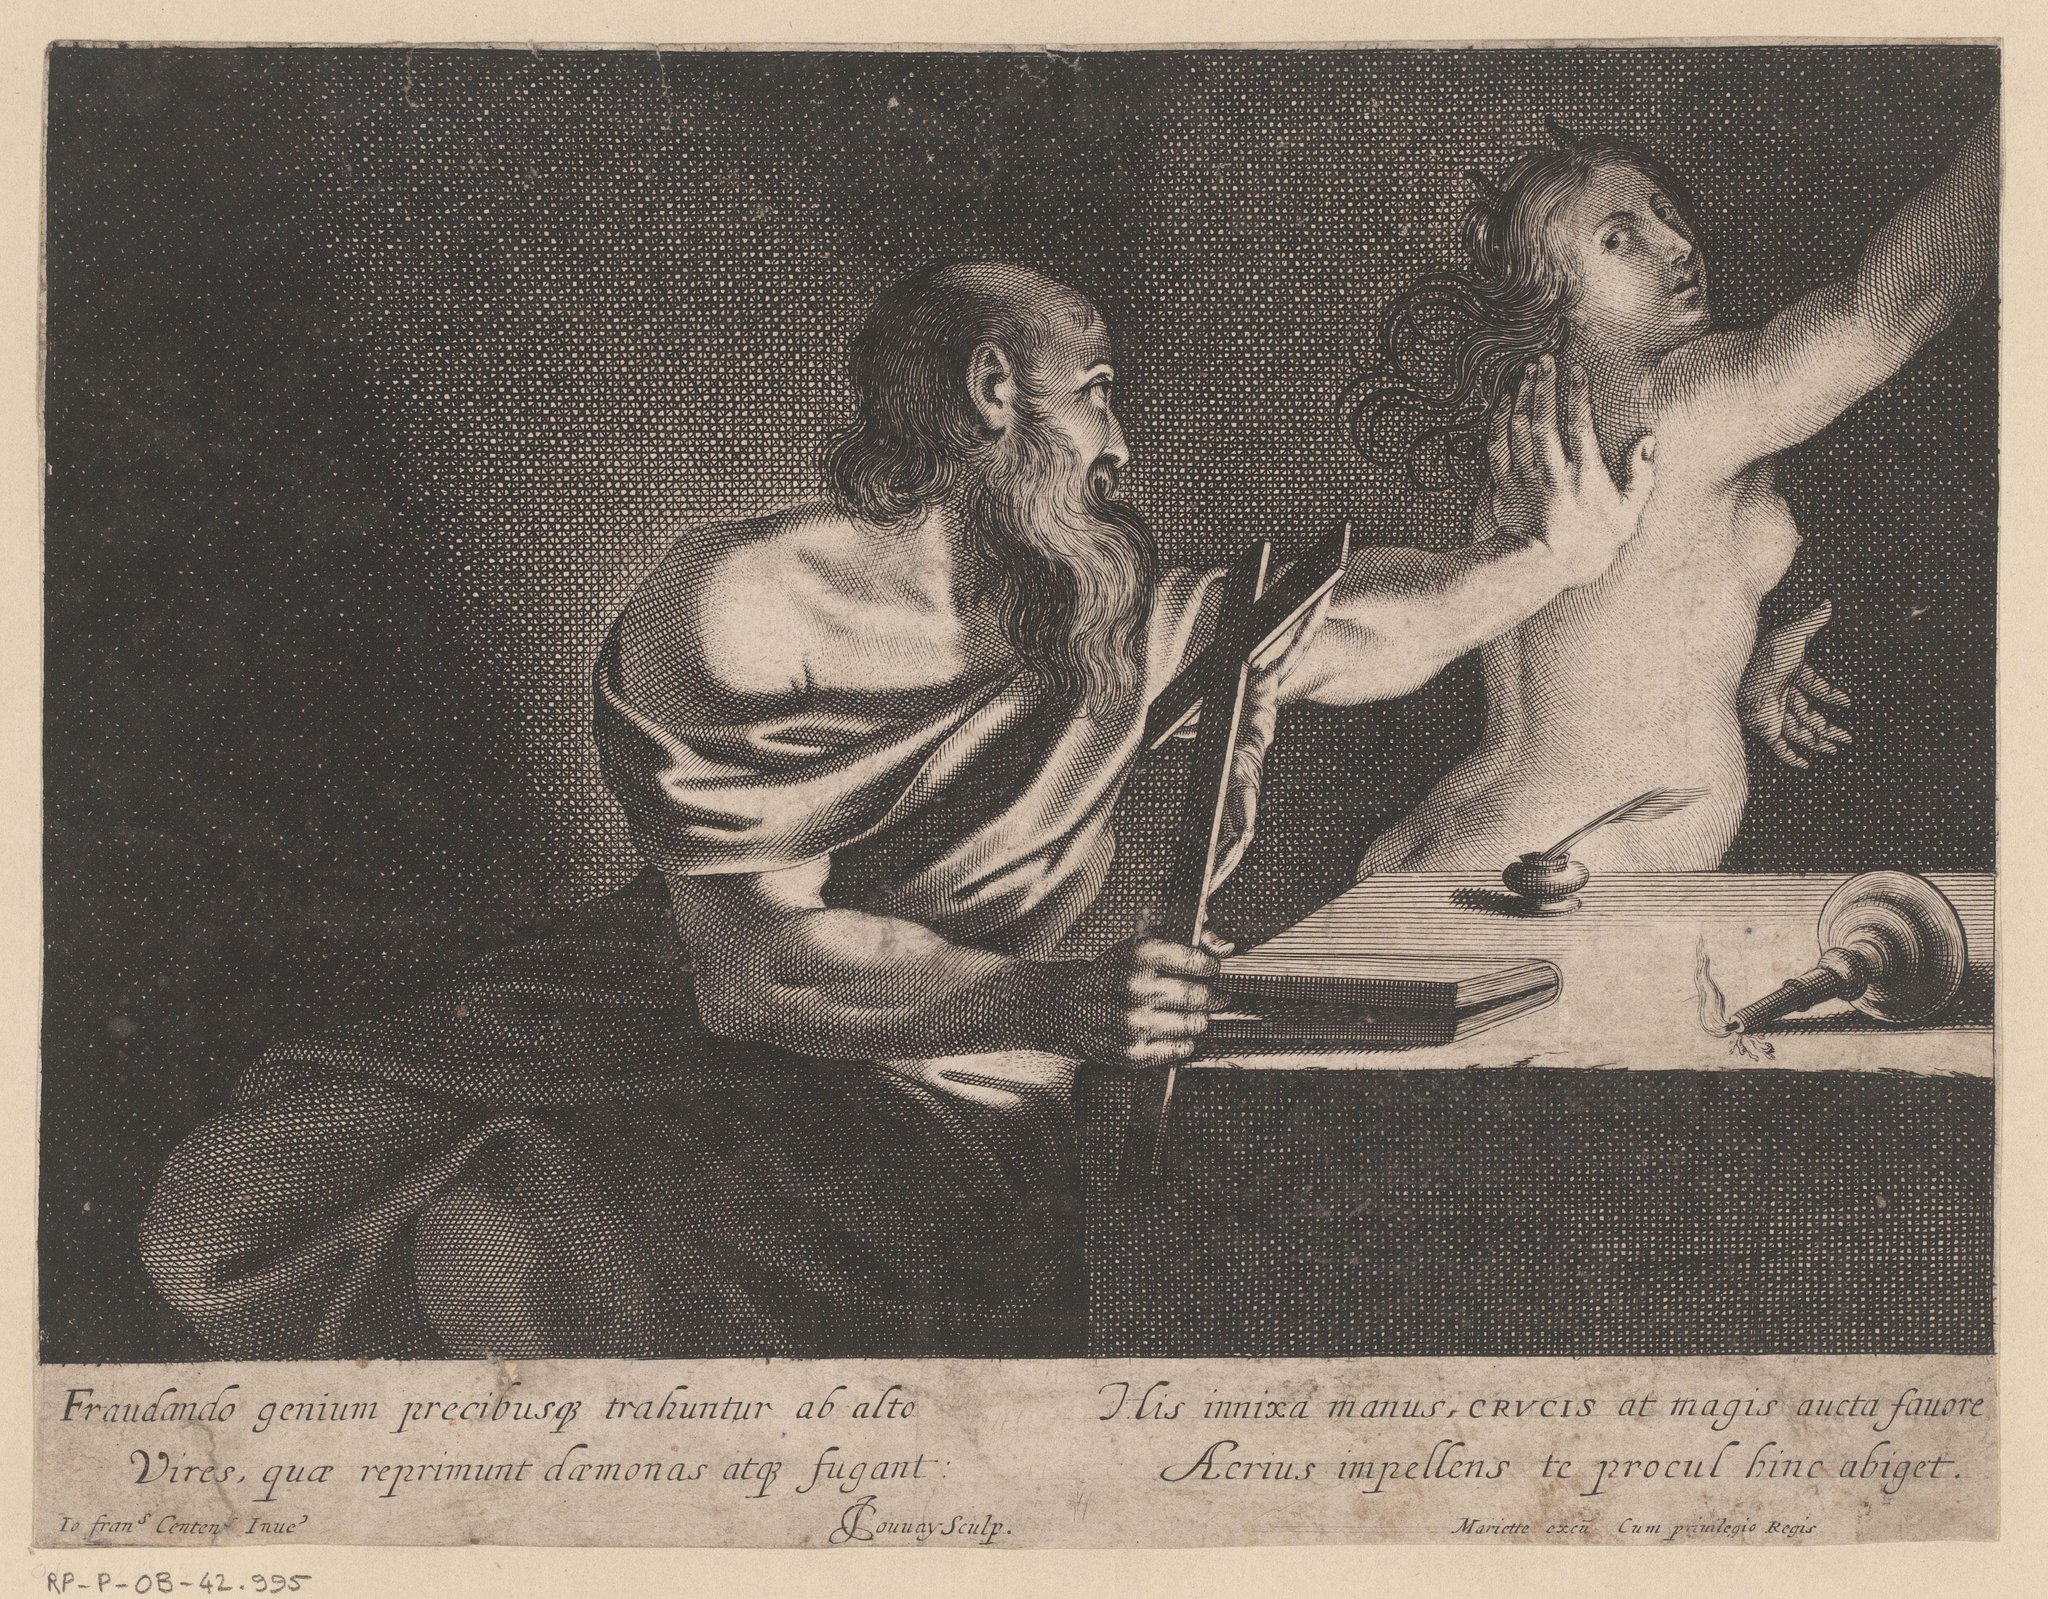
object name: print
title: Verzoeking van Antonius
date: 1632-1657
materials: paper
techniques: engraving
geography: paris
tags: the erotic visions of st. antony abbot: he is tempted by (naked) women, but drives them off by praying, or by showing them a crucifix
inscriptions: collector's mark: Lugt 240